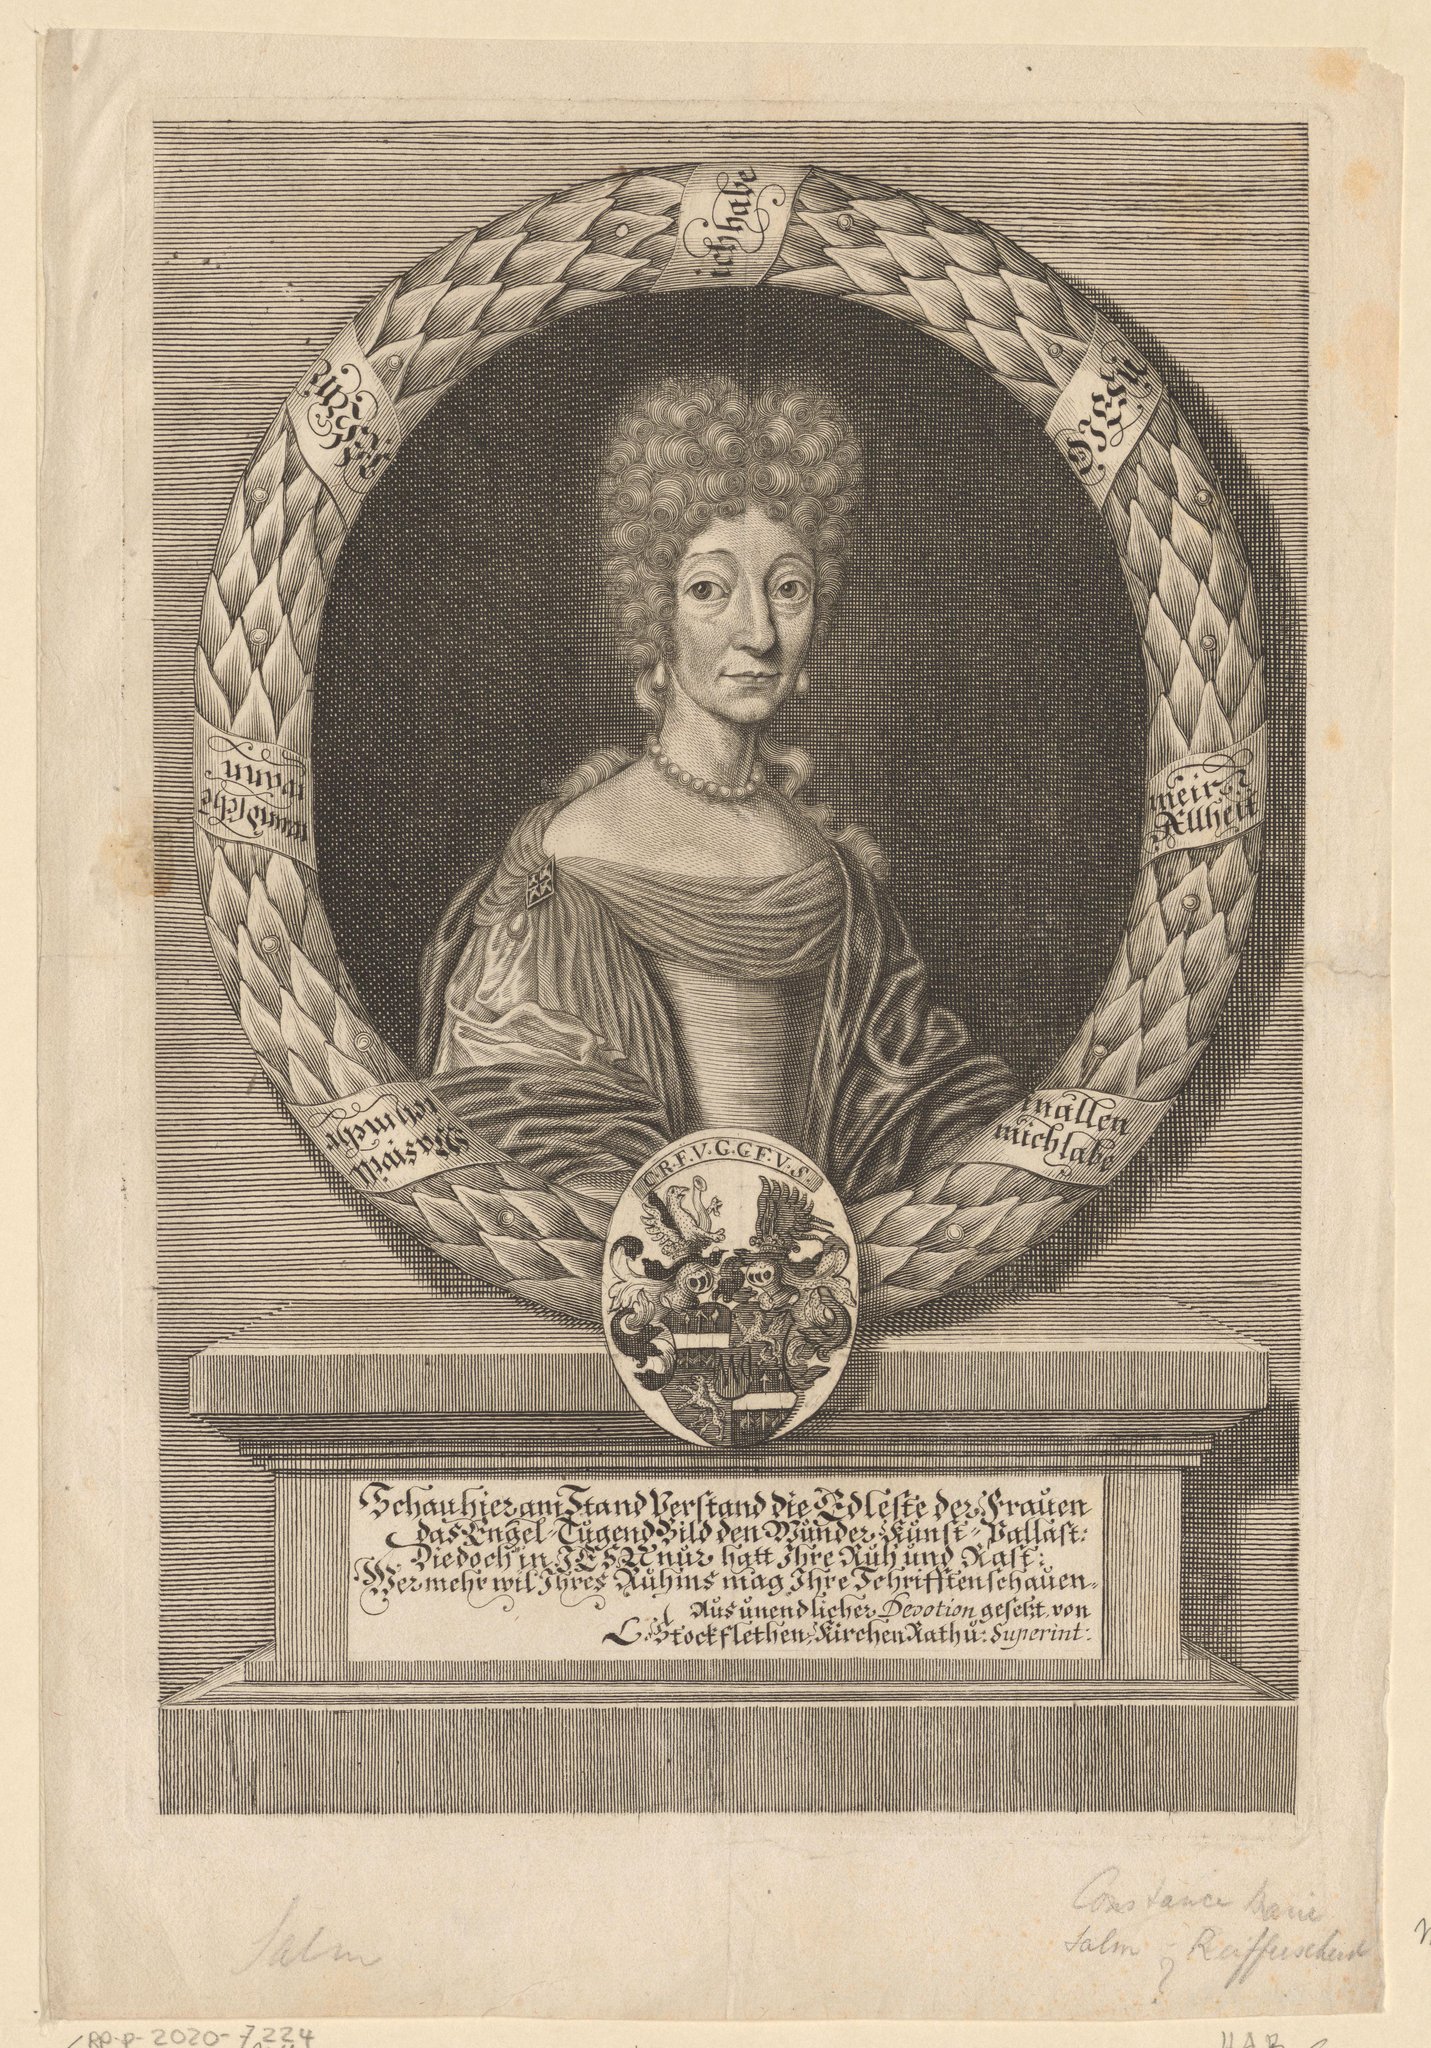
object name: print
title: Portret van Catharina Regina von Greiffenberg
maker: Anonymous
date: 1650-1750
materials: paper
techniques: engraving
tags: historical persons, writer, poet, author